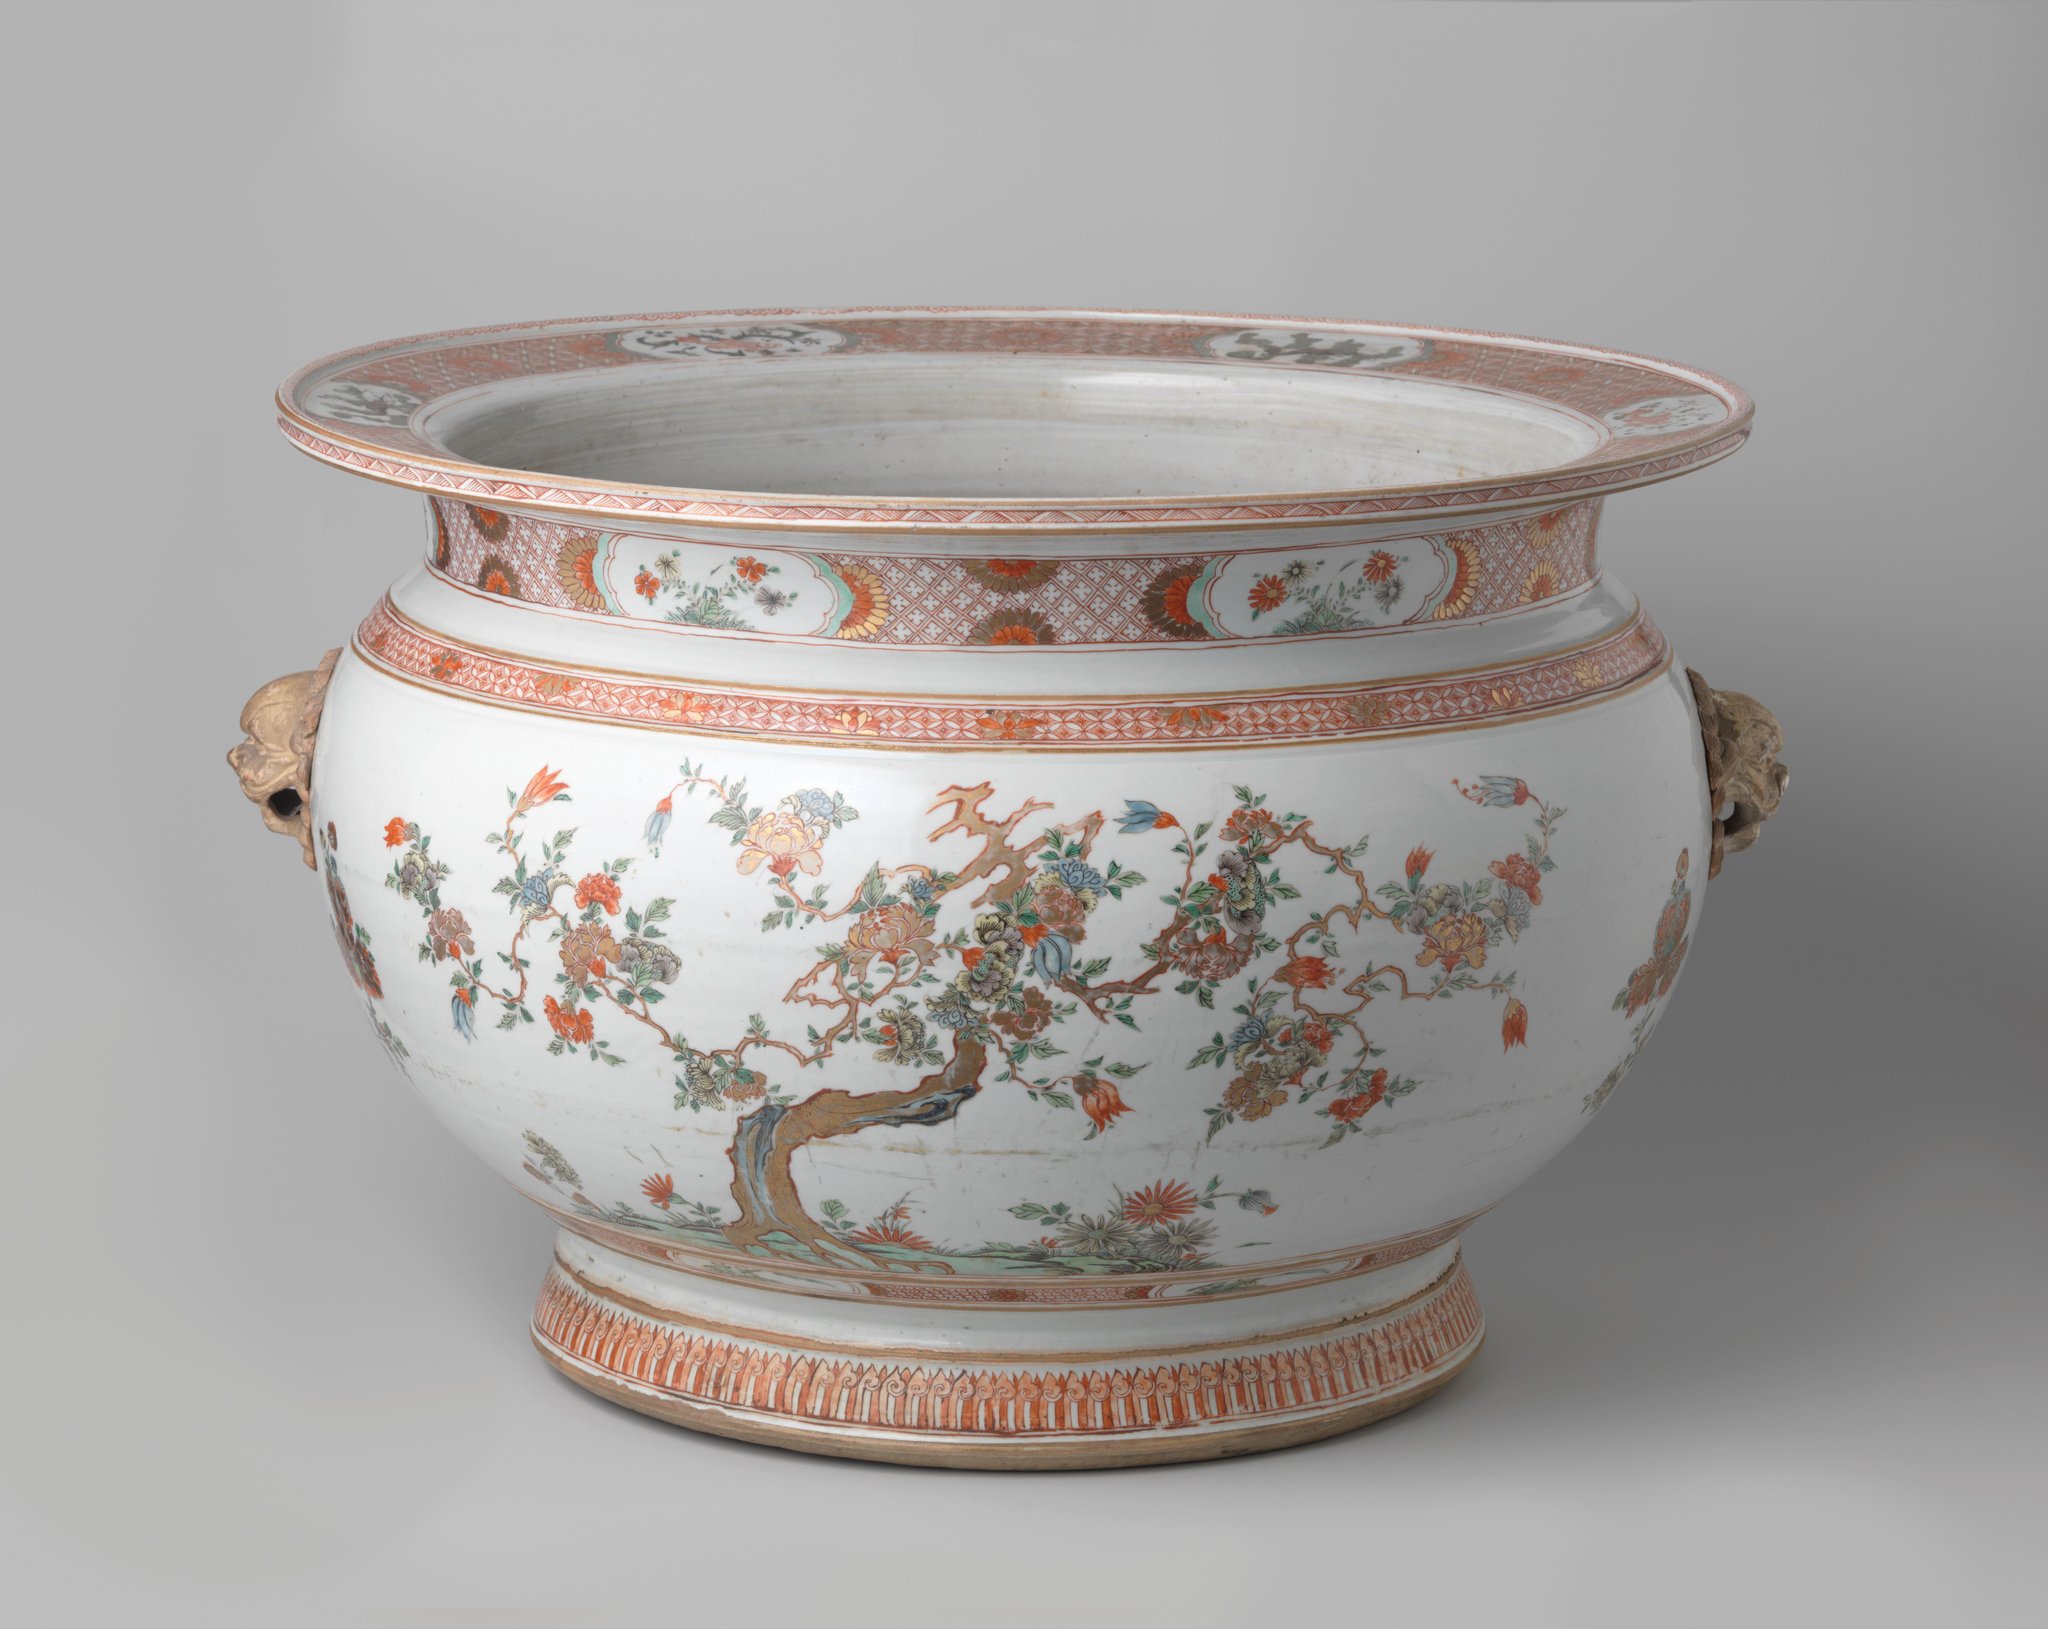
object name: viskom, vissenkom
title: Fish bowl with flowering plants, animals and moulded lion-heads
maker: Anonymous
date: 1725-1749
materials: glaze, gold, paint, porcelain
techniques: firing, gilding, turning, vitrification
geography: china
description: Vissenkom van porselein met een bolvormig lichaam, platte rand en spreidende voet, beschilderd op het glazuur in blauw, rood, groen, geel, aubergine, zwart en goud. Op de buitenwand tweemaal een boom met bloeiende planten. Hiertussen tweemaal een gemodelleerde kop van een shishi (leeuwhond) als ringhouders met daaronder een bloeiende chrysant. Op de schouder een band met servetwerk onderbroken door afwisselend hele en halve lotusbloemen. De onderzijde van de wand met een band met chrysanten op kikkerdril onderbroken door cartouches met planten. De nek met servetwerk met halve chrysanten onderbroken door zes gelobde cartouches met bloeiende planten (aster, prachtanjer). Op de binnenrand servetwerk met chrysanten onderbroken door gelobde cartouches met een karper of een garnaal tussen waterplanten. De buitenrand met arceerwerk. Op de voet een band met gestileerde bladmotieven. Binnnenzijde en binnen de voetring ongeglazuurd. Leeuwenkoppen licht beschadigd; deel email van de binnenrand missend. Famille verte.